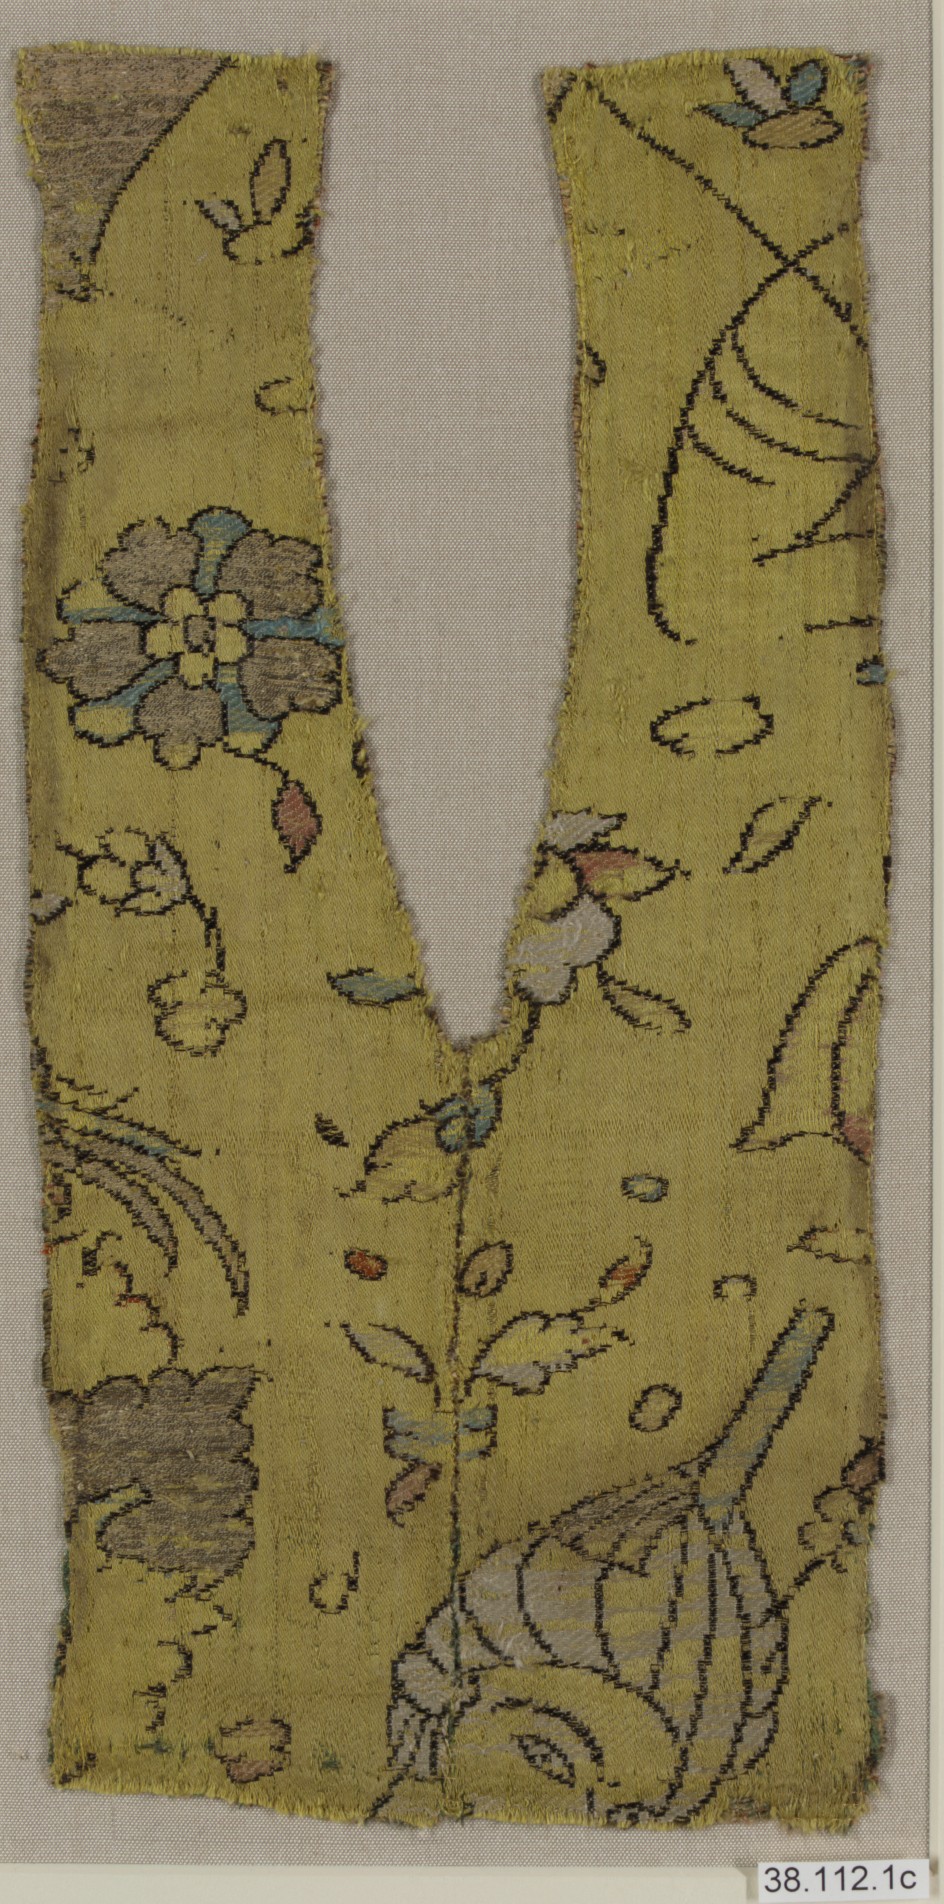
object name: textile fragment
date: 1501-1600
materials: metal thread, silk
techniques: brocade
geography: iran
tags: faces,flowers